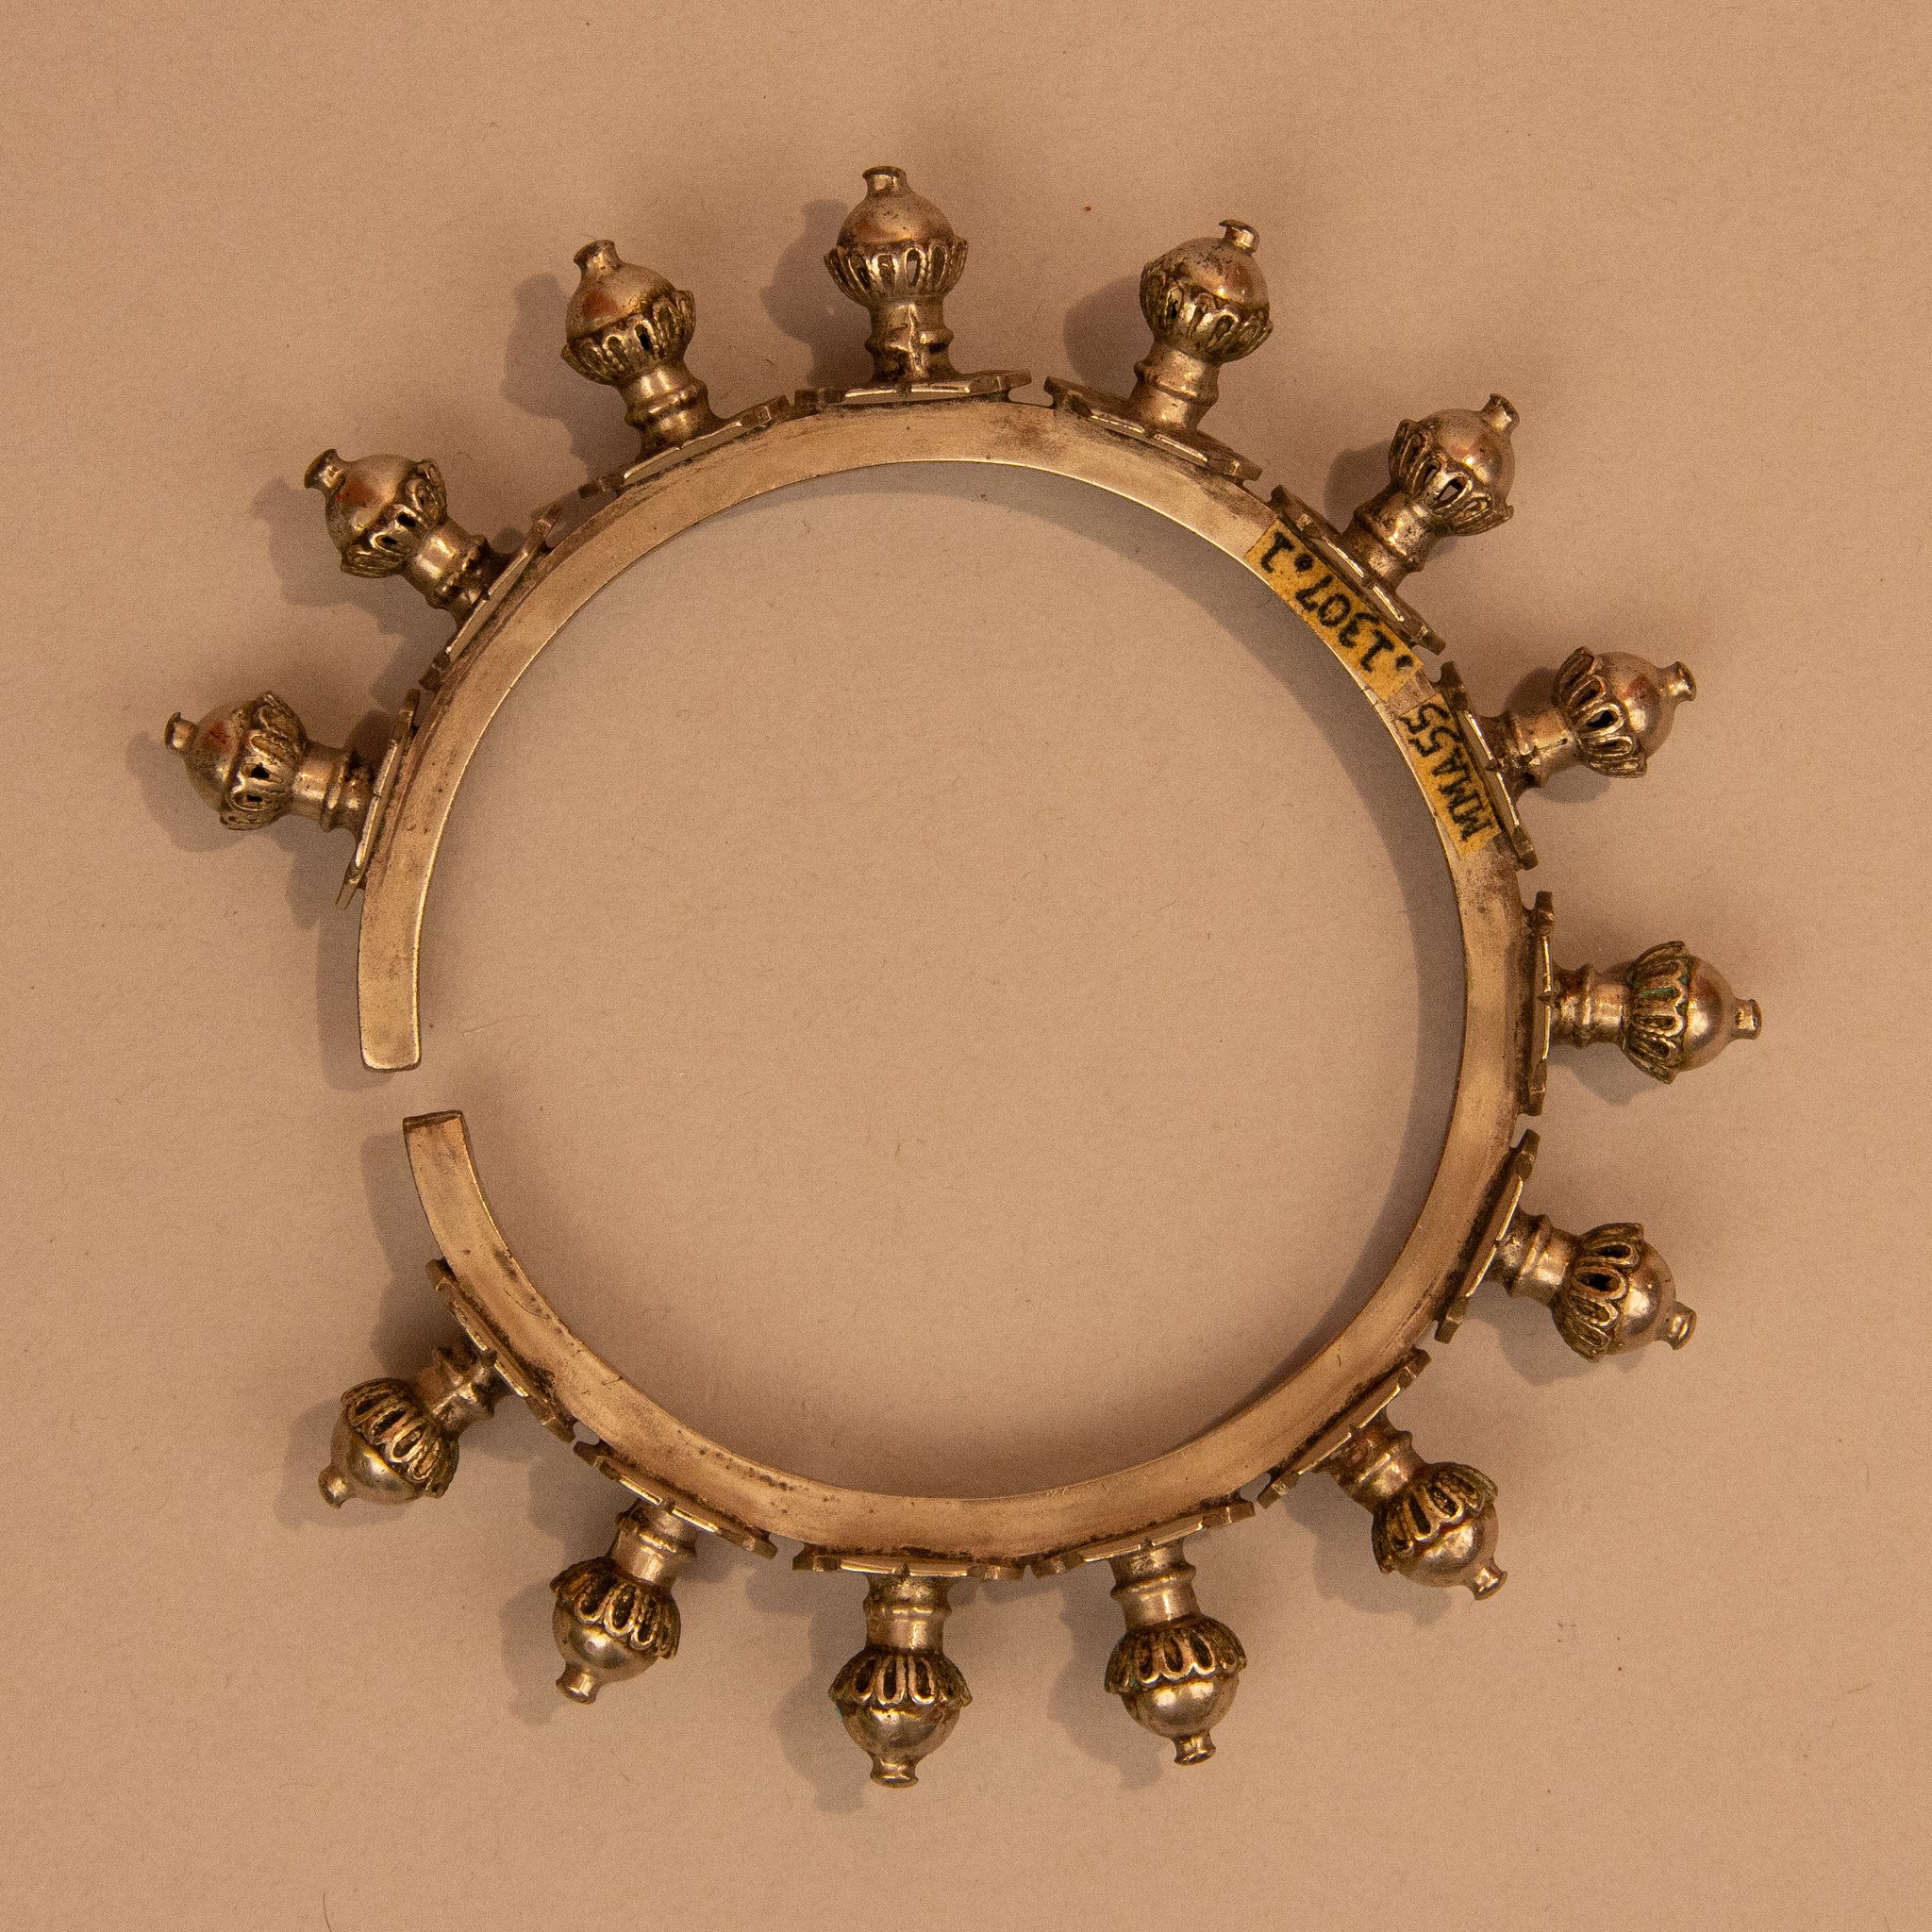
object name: bracelet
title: Bracelet, One of a Pair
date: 1801-1900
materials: silver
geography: india